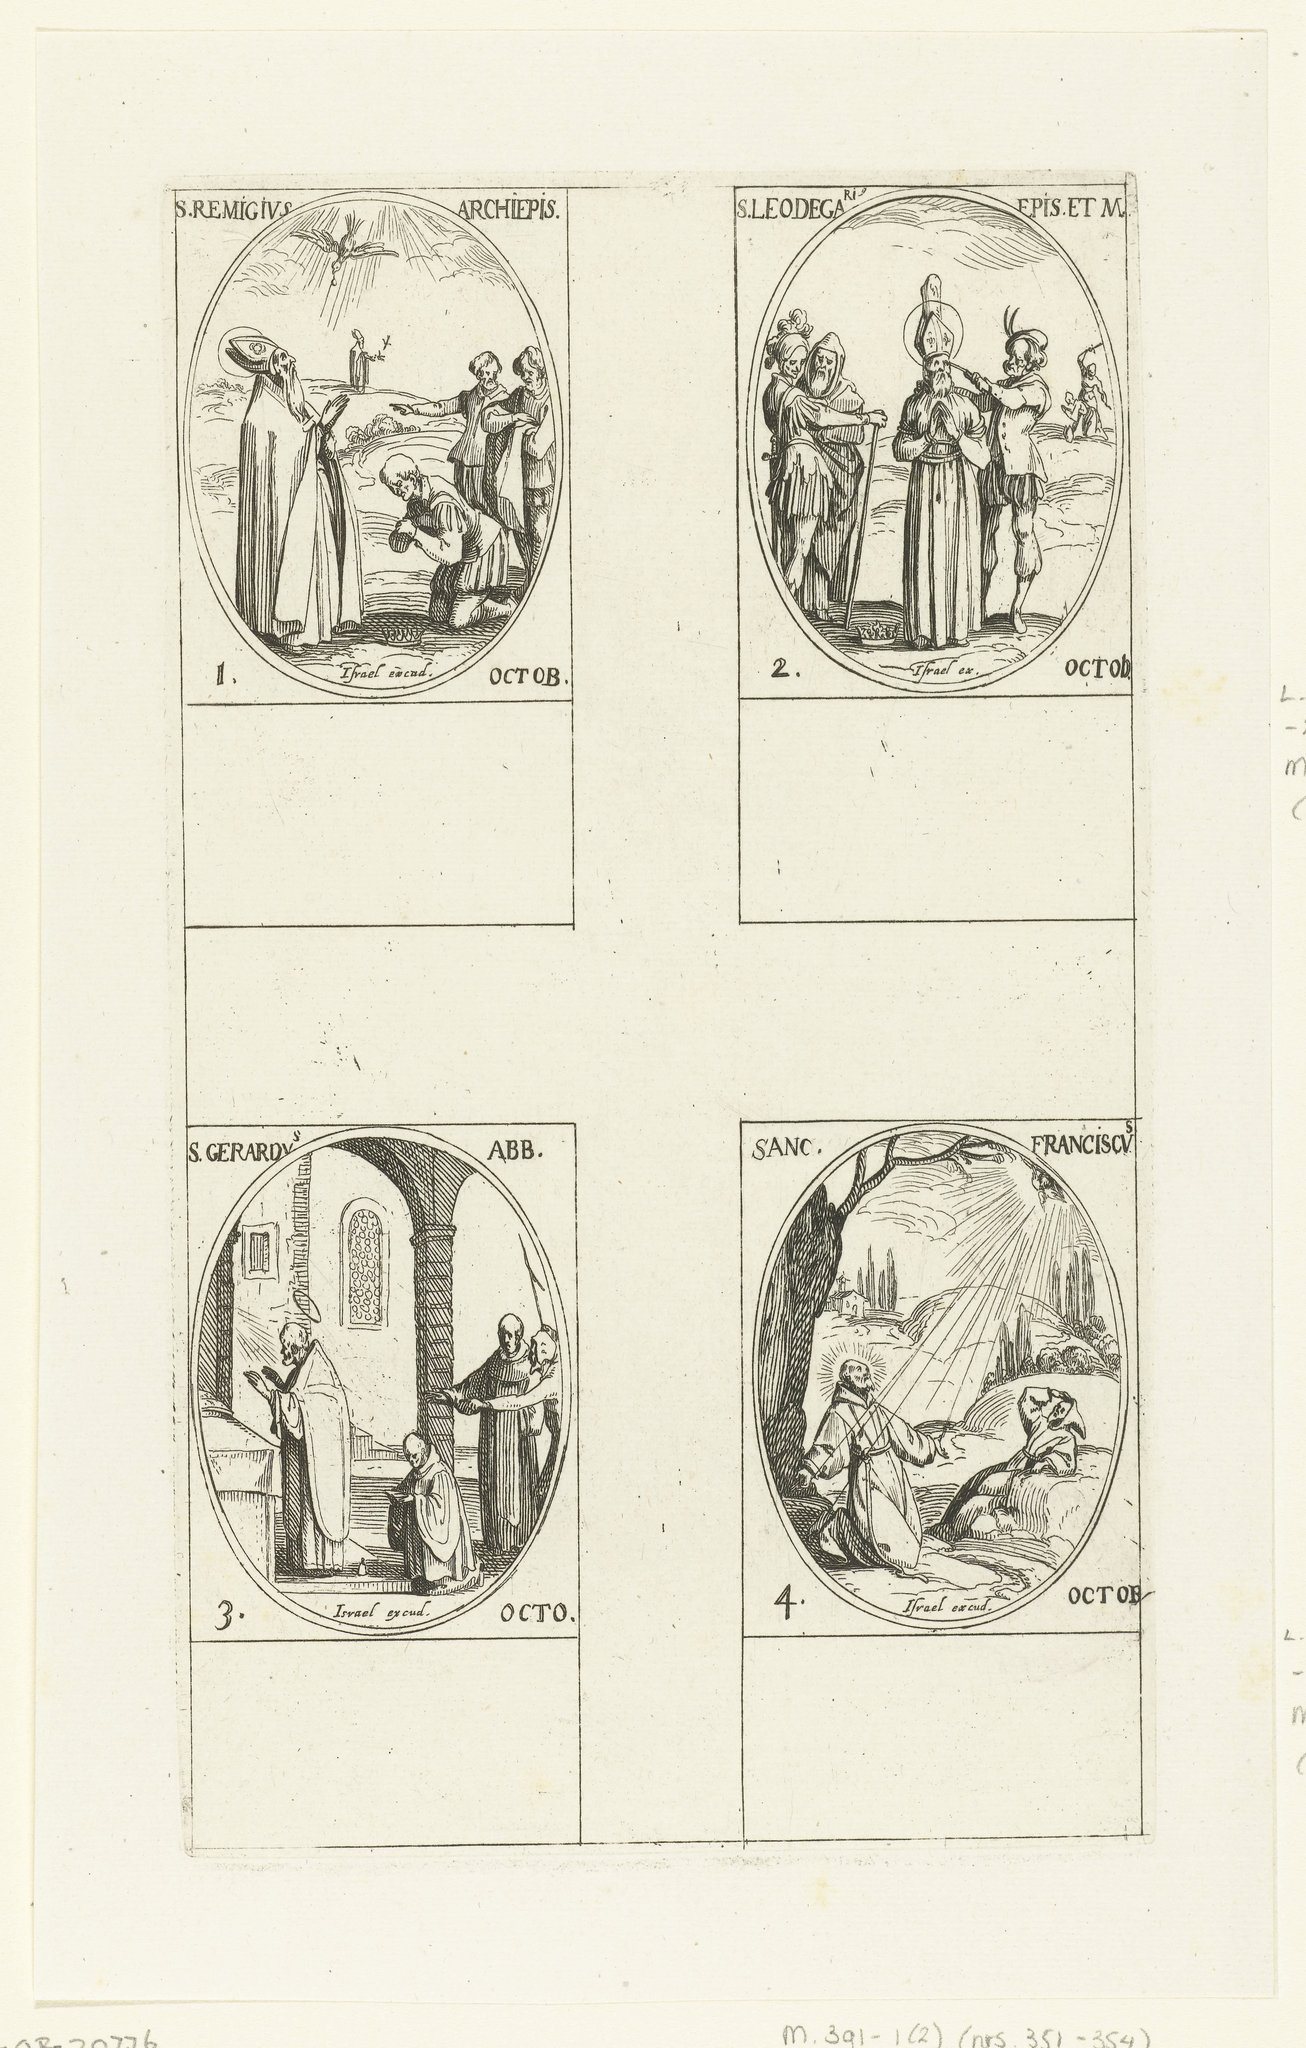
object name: print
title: Alle heiligen en de Christelijke feestdagen van het jaar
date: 1632-1636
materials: paper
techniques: etching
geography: nancy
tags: stigmatization of st. francis of assisi: in retreat on mount alverna, he beholds a vision of christ on the cross enveloped by wings (like a seraph with six wings); rays passing down to the body of the kneeling saint form the marks of the five wounds of christ, male saints (with name), st. remigius baptizes clovis, king of the franks; perhaps a dove with a phial in its beak appears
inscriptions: collector's mark: Lugt 240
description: Blad met vier ovale voorstellingen, elk met opschrift en datum in het Latijn: linksboven de Heilige Remigius van Reims die van een vogel de olie ontvangt om koning Chlodovech (Clovis) mee te dopen, rechtsboven de Heilige Leodegard van Autun die door een beul blind gemaakt wordt, linksonder de Heilige Gerardus van Brogne bij een altaar, rechtsonder de Heilige Franciscus van Assisi die de stigmata ontvangt. Deze prent is onderdeel van een serie prenten met voorstellingen van de heiligen en de christelijke feestdagen van het jaar. Er zijn steeds vier scènes van één plaat op één blad gedrukt. Inclusief bijbehorend titelblad en frontispice gaat het in totaal om 124 platen (490 voorstellingen). De drie platen met de laatste 12 scènes (de veranderlijke christelijke feestdagen) zijn in de derde staat versneden tot 12 kleine plaatjes, en met een apart titelblad uitgegeven.